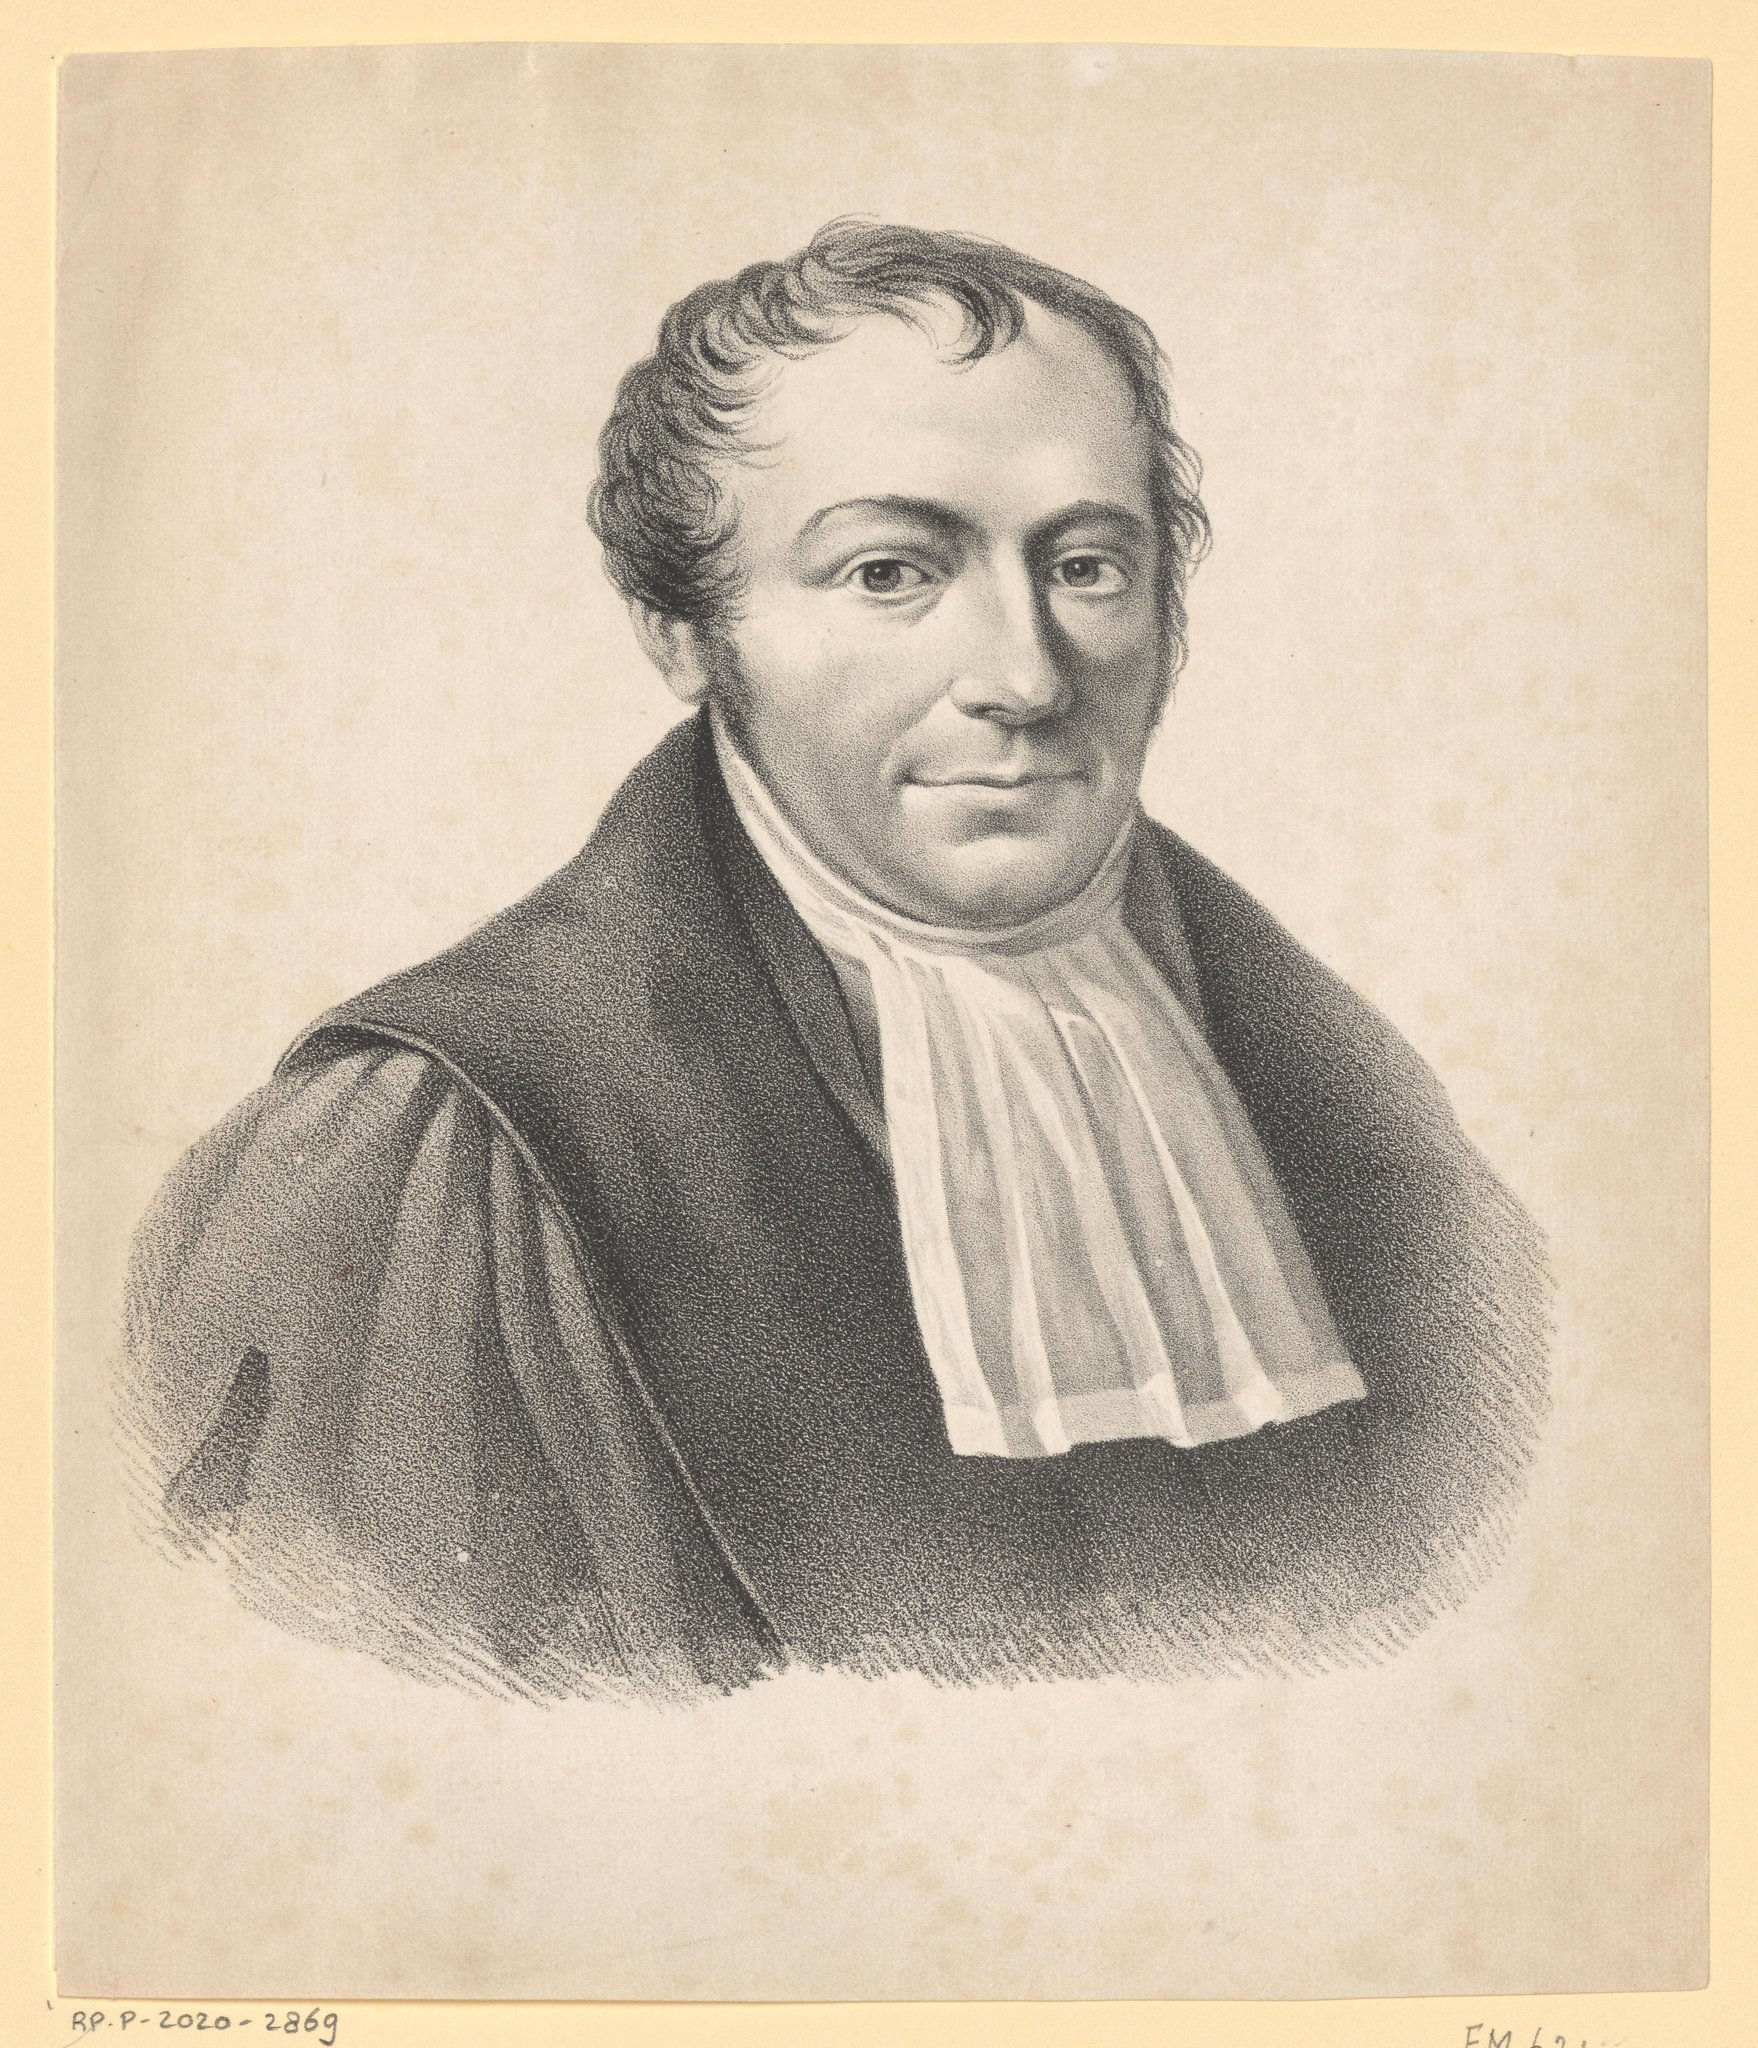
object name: print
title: Portret van Hendrik Bosscha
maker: Anonymous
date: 1820-1840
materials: paper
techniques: lithograph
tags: amsterdam, scholar, philosopher, historical persons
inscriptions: inscription: ‘Prof Hk Bosscha 1821-1829’